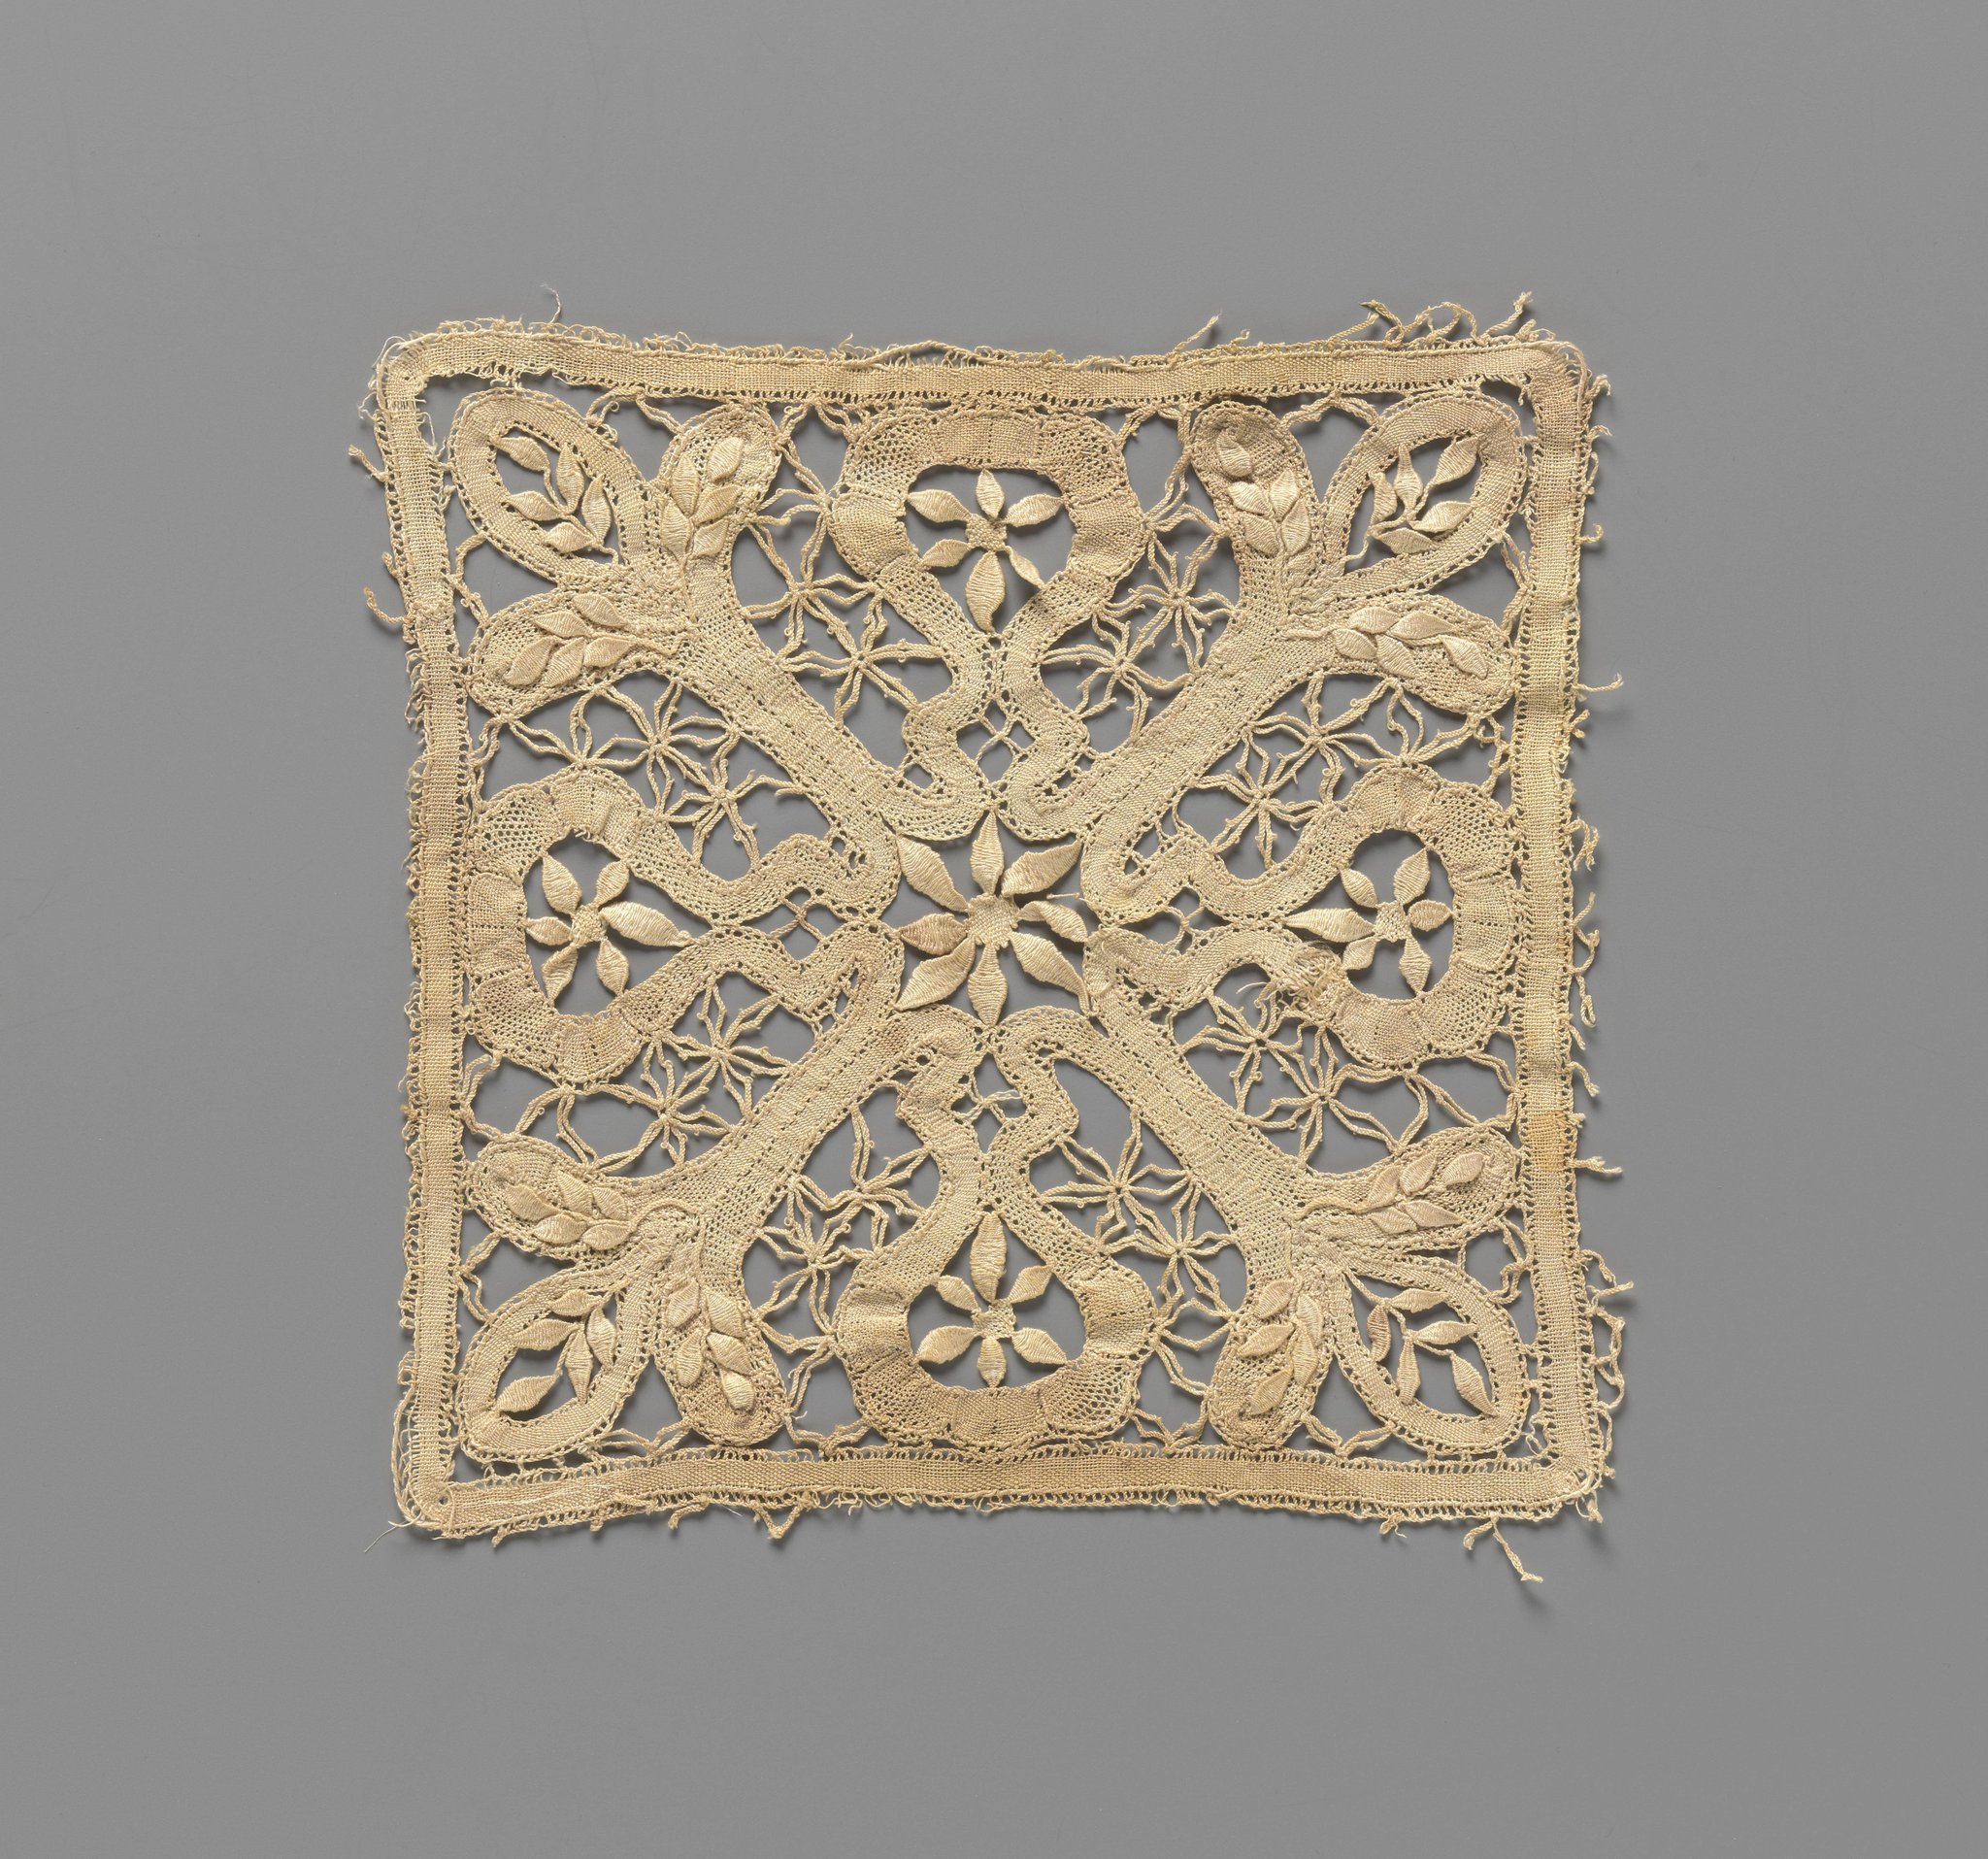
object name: kleed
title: Kleed van kloskant met symmetrisch patroon gevormd door een lint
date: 1914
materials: linen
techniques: lace, tally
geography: amsterdam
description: Kleed van naturelkleurig kloskant: lintkant. Vierkant model. Het patroon is symmetrisch en wordt gevormd door een doorlopend lint. Het lint vormt in elke hoek een smalle druppelvormige bloem, tussen twee bladeren op een lange steel die naar het centrum wijst. Tussen de bloemen in de hoeken vormt het lint een brede lus, met in elk een bloem. In het centrum van het kleedje staat een bloem met bloemblaadjes in vormslag. De bloemen in de lussen zijn ook gemaakt in vormslag, net als de blaadjes aan het takje dat in elke smalle druppelvormige bloem staat. Lint van linnen- en netslag. De bloemblaadjes zijn gemaakt in vormslag. De motieven zijn met elkaar verbonden door gepicoteerde vlechtjes die sterren vormen.